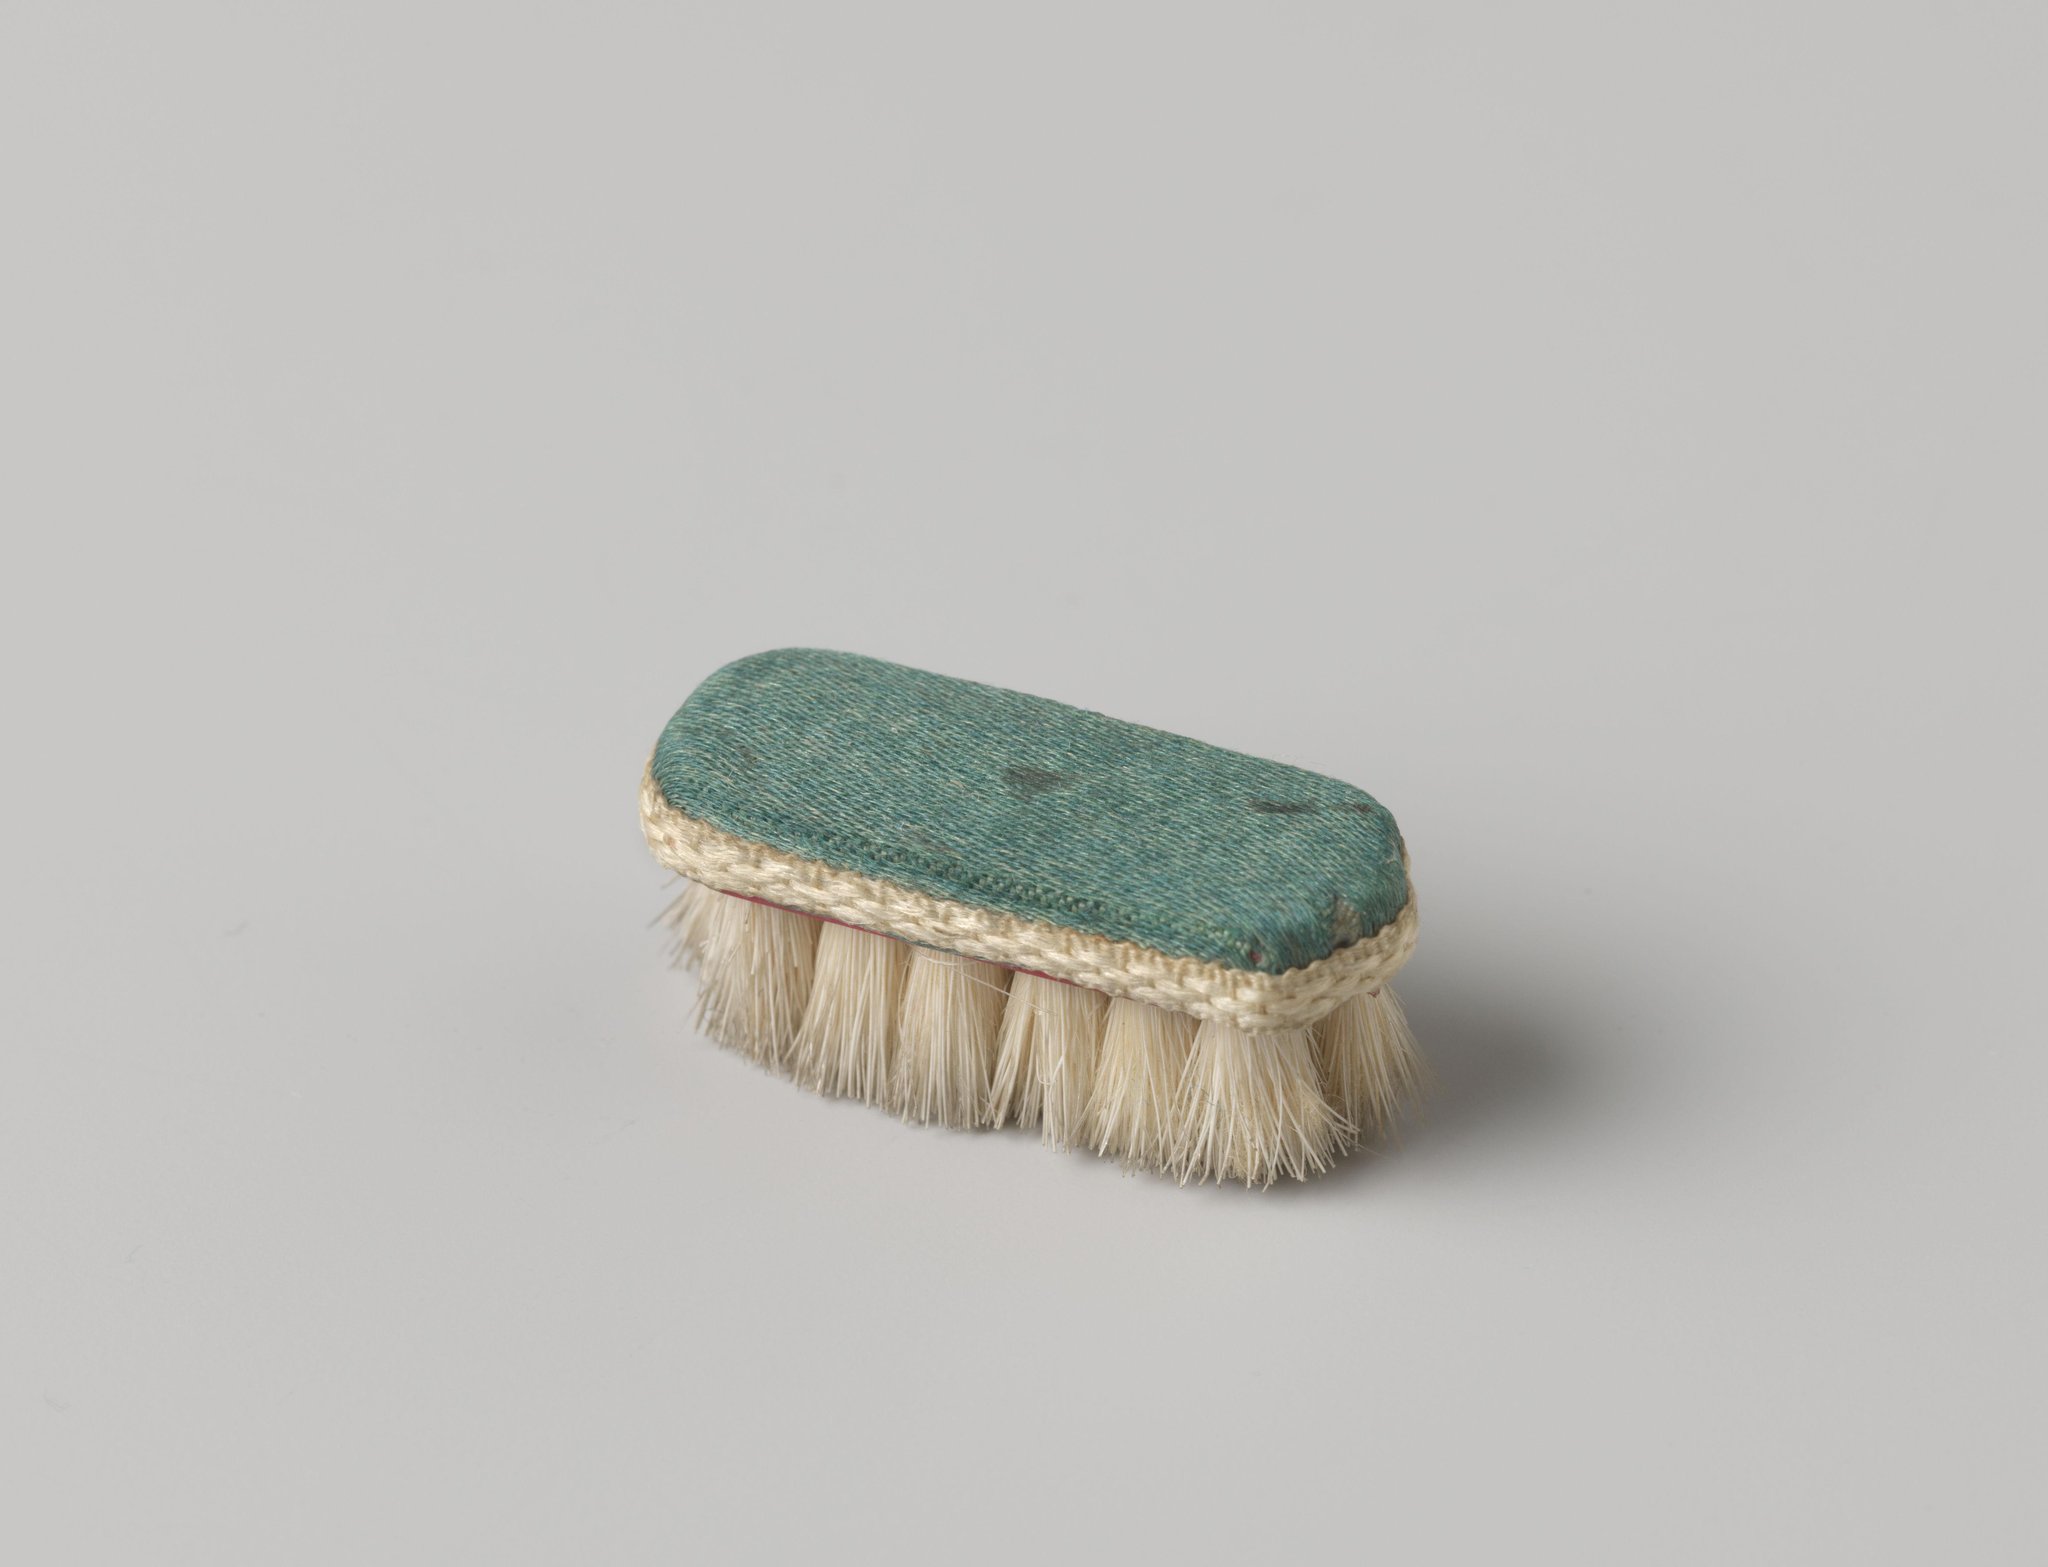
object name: schuier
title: Schuier, overtrokken met blauw-groene zijde, afgezet met wit band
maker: Anonymous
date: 1750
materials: lacquer, silk, wax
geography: amsterdam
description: Een schuier met een met blauw-groene zijde overtrokken rug, afgezet met een wit zijden bandje. De haren van de schuier zijn gevat in roze gekleurde lak of was